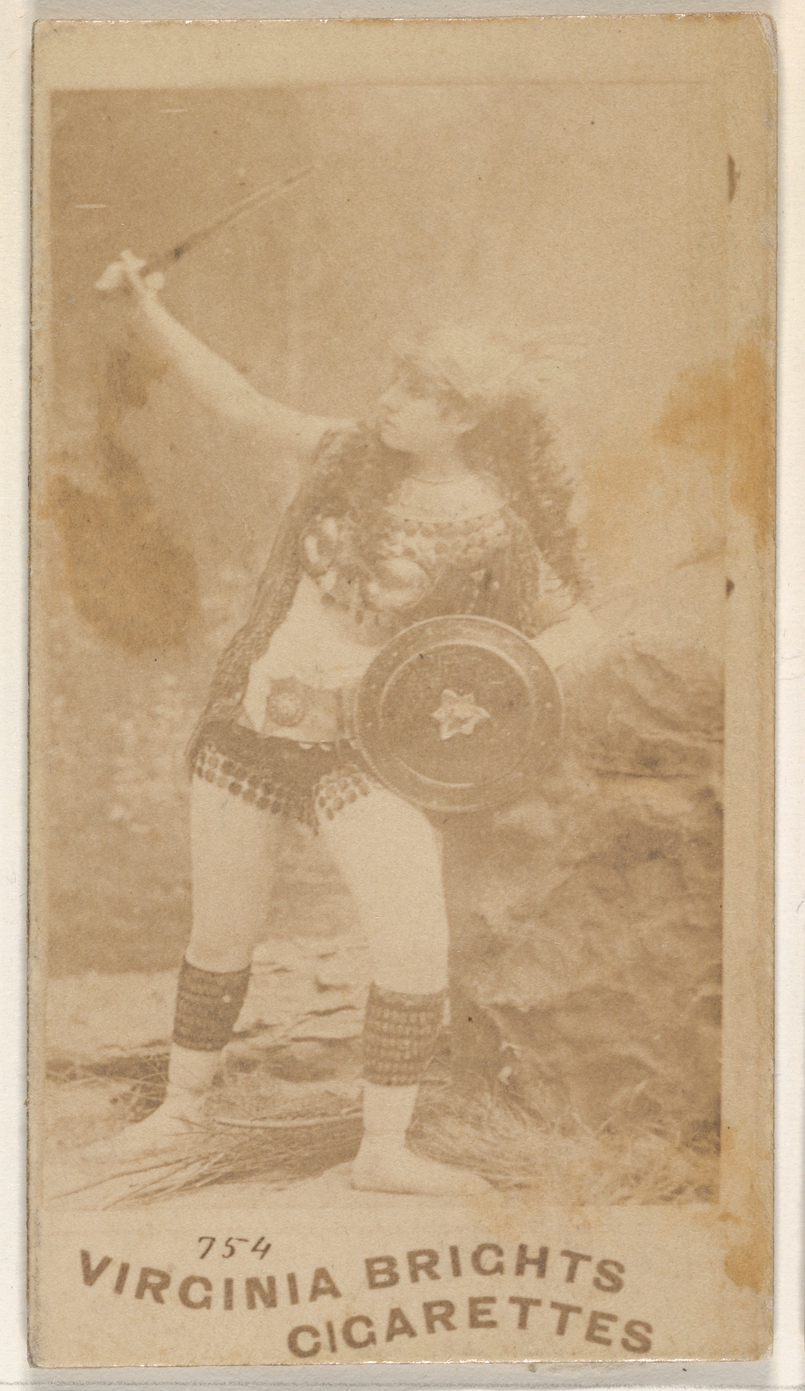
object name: photograph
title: Card 754, from the Actors and Actresses series (N45, Type 5) for Virginia Brights Cigarettes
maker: allen & ginter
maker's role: publisher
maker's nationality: american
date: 1888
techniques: albumen silver print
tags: portraits,women,actresses